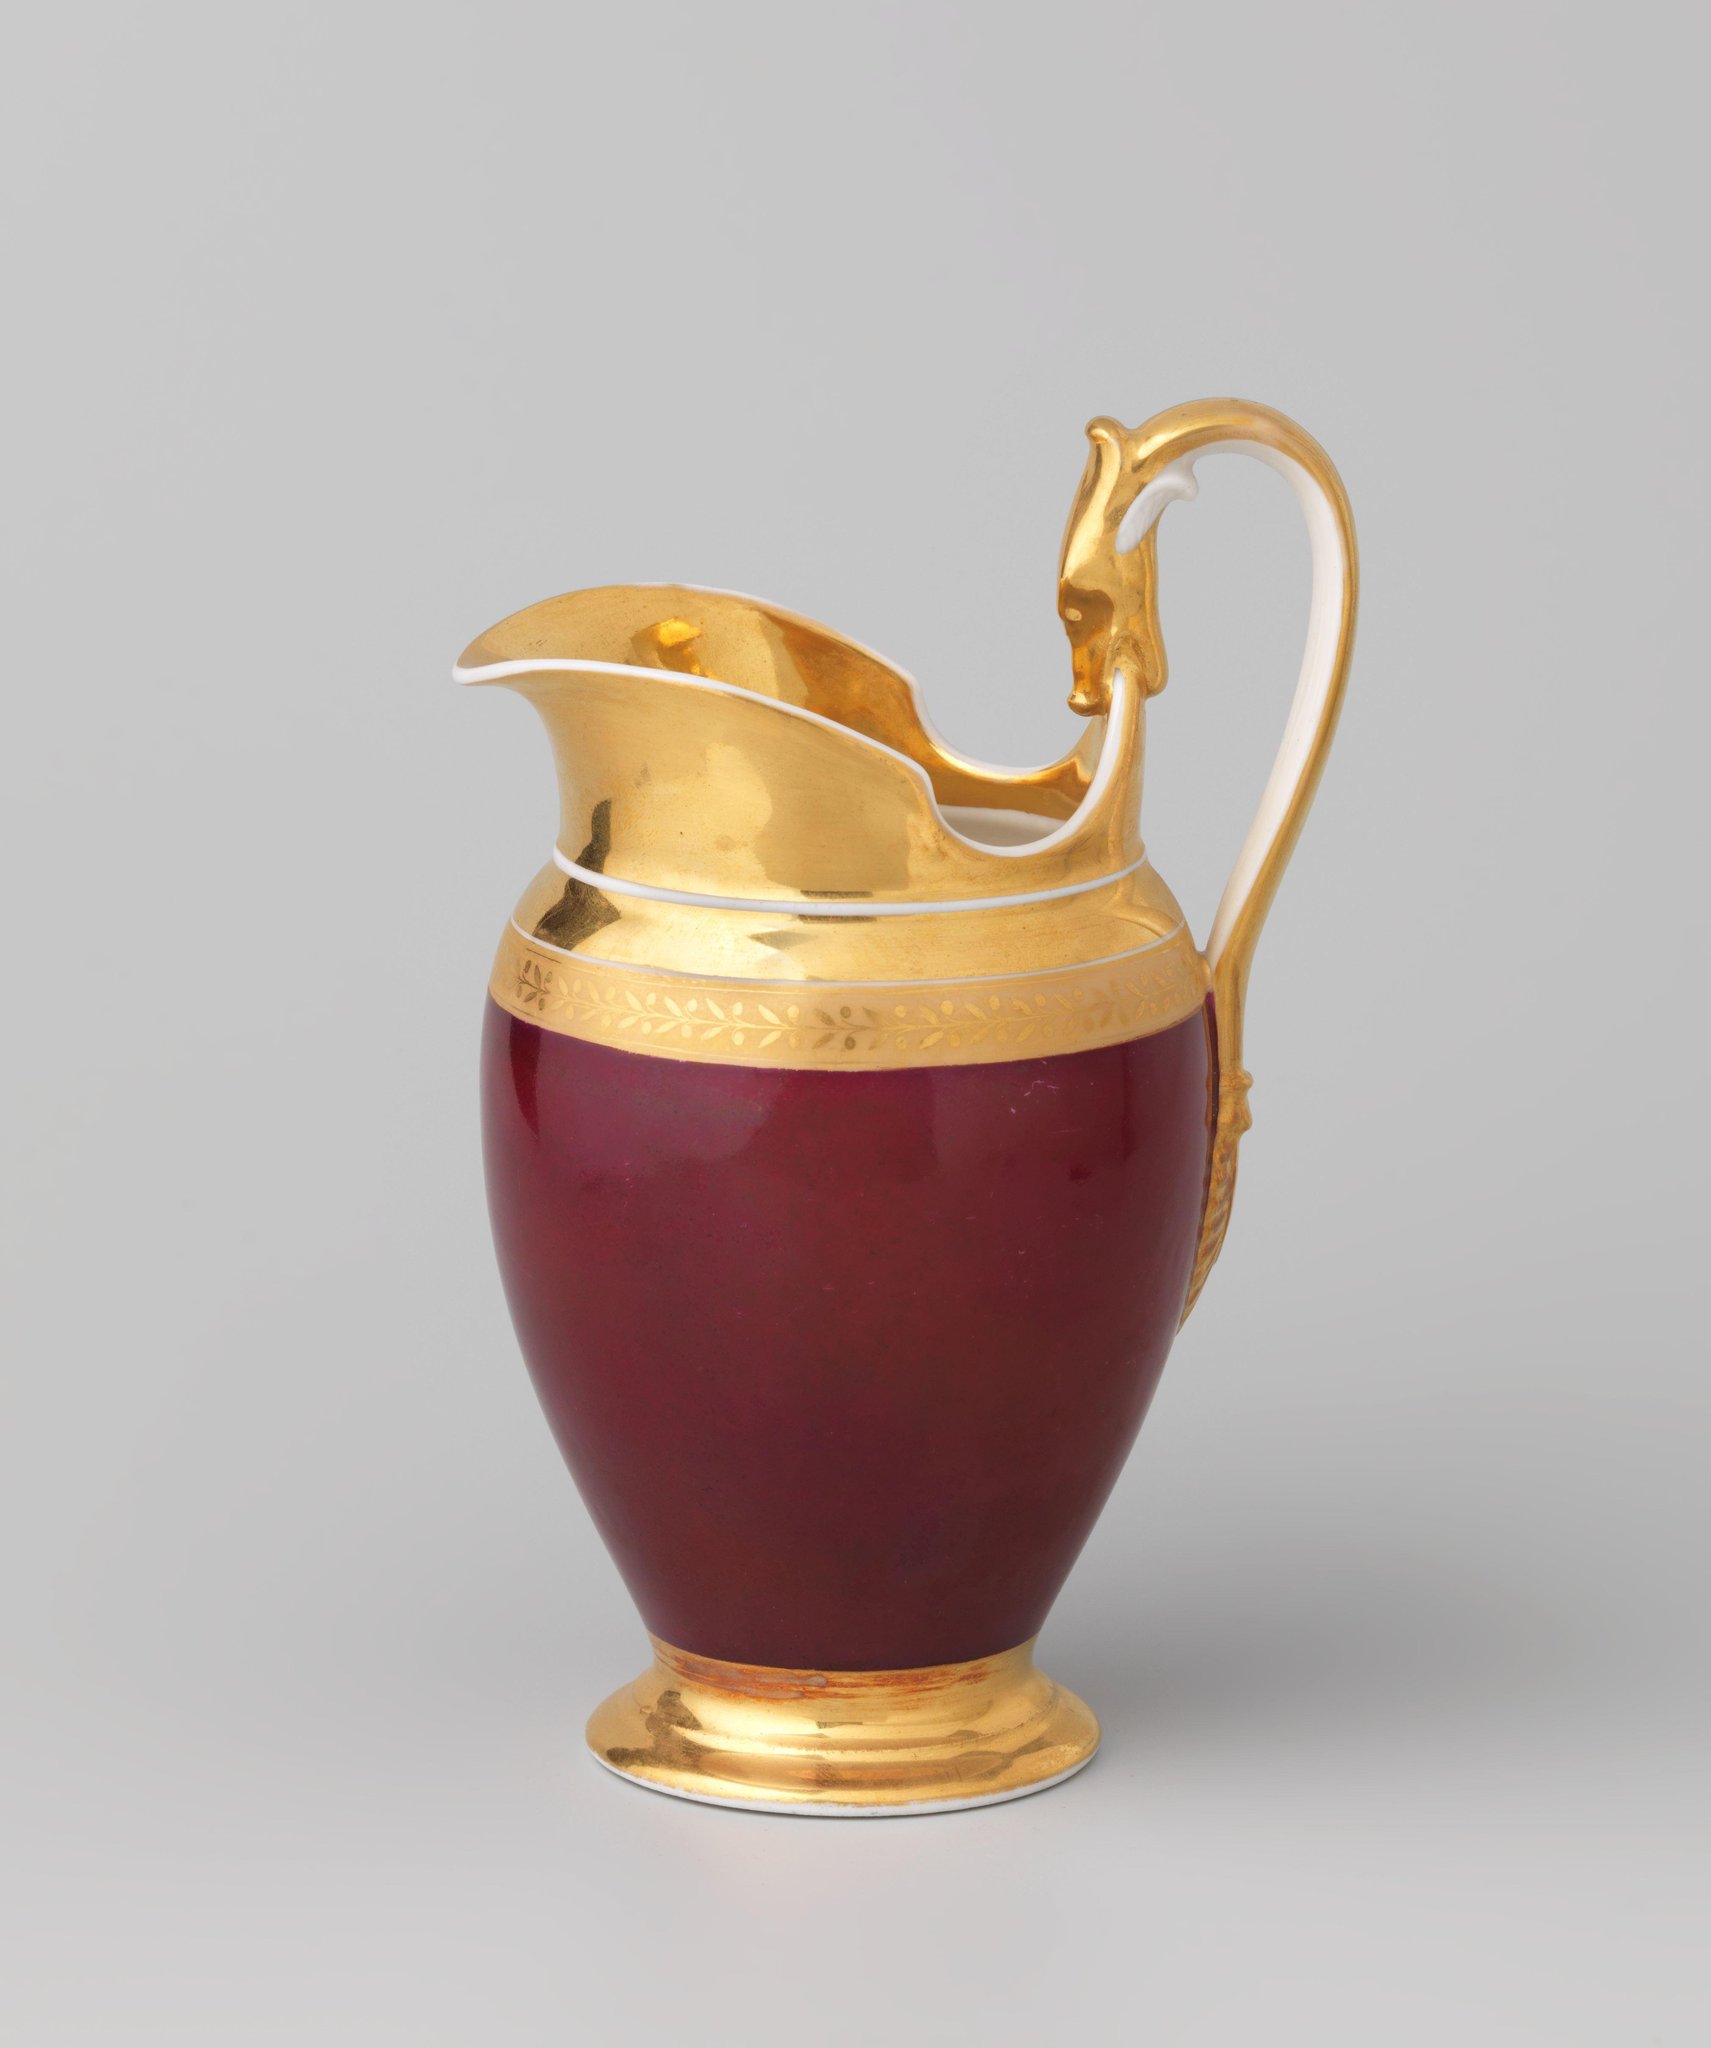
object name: service set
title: Jug with gold borders on a red ground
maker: Anonymous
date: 1800-1824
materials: glaze, gold, paint, porcelain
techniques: firing, forming, gilding, turning, vitrification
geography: france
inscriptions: mark: ‘II’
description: Kan van porselein, bedekt op het glazuur met rood en goud. De kan heeft een eivormig lichaam op een spreidende voet en een wijde nek met aan één zijde een brede schenkrand. Het hoge oor heeft bij de basis een palmet en het uiteinde is in de vorm van een slangenkop, die in de rand bijt. De buik is bedekt met rood en de voet, schouder, nek en het oor met goud. Op de schouder een bloemrank in één van de gouden banden. Gemerkt op de onderzijde met II. Empire.